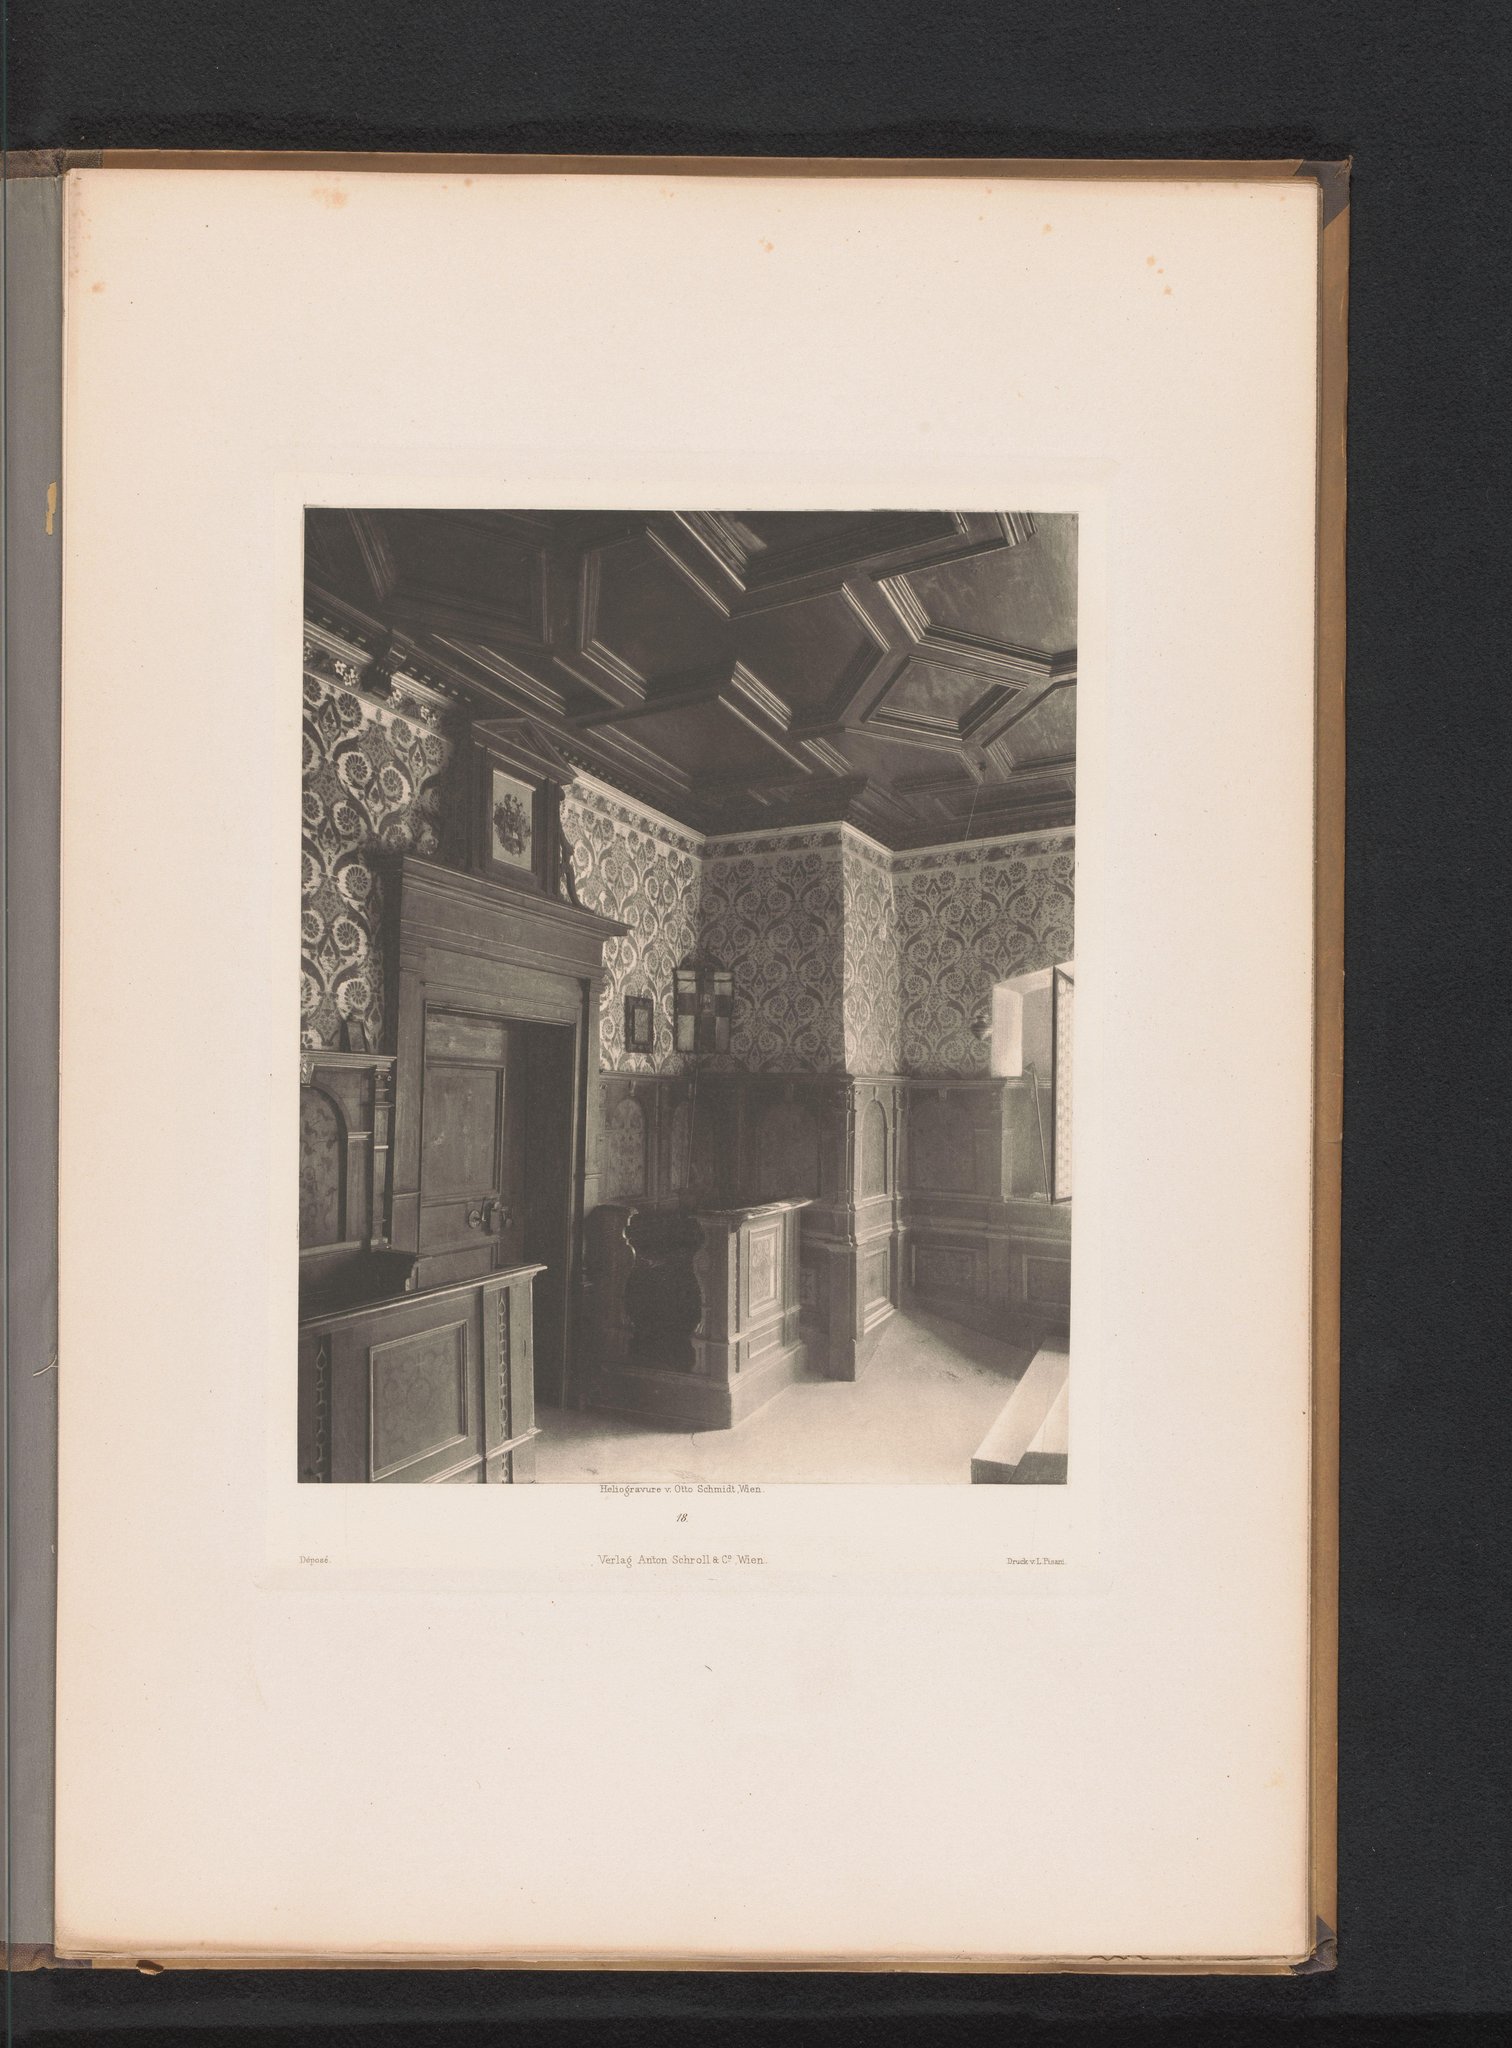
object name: photomechanical print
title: Gezicht op het interieur van de kapel van Slot Velthurns bij Bressanone, Italië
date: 1886-1891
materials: paper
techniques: photoaquatint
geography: vienna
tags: chapel (interior of the house), castle - aa - civic architecture: inside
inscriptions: inscription: ‘Déposé.’, number: ‘18.’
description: Deze prent maakt deel uit van een omslag met dertig prenten en drie tekstbladen.